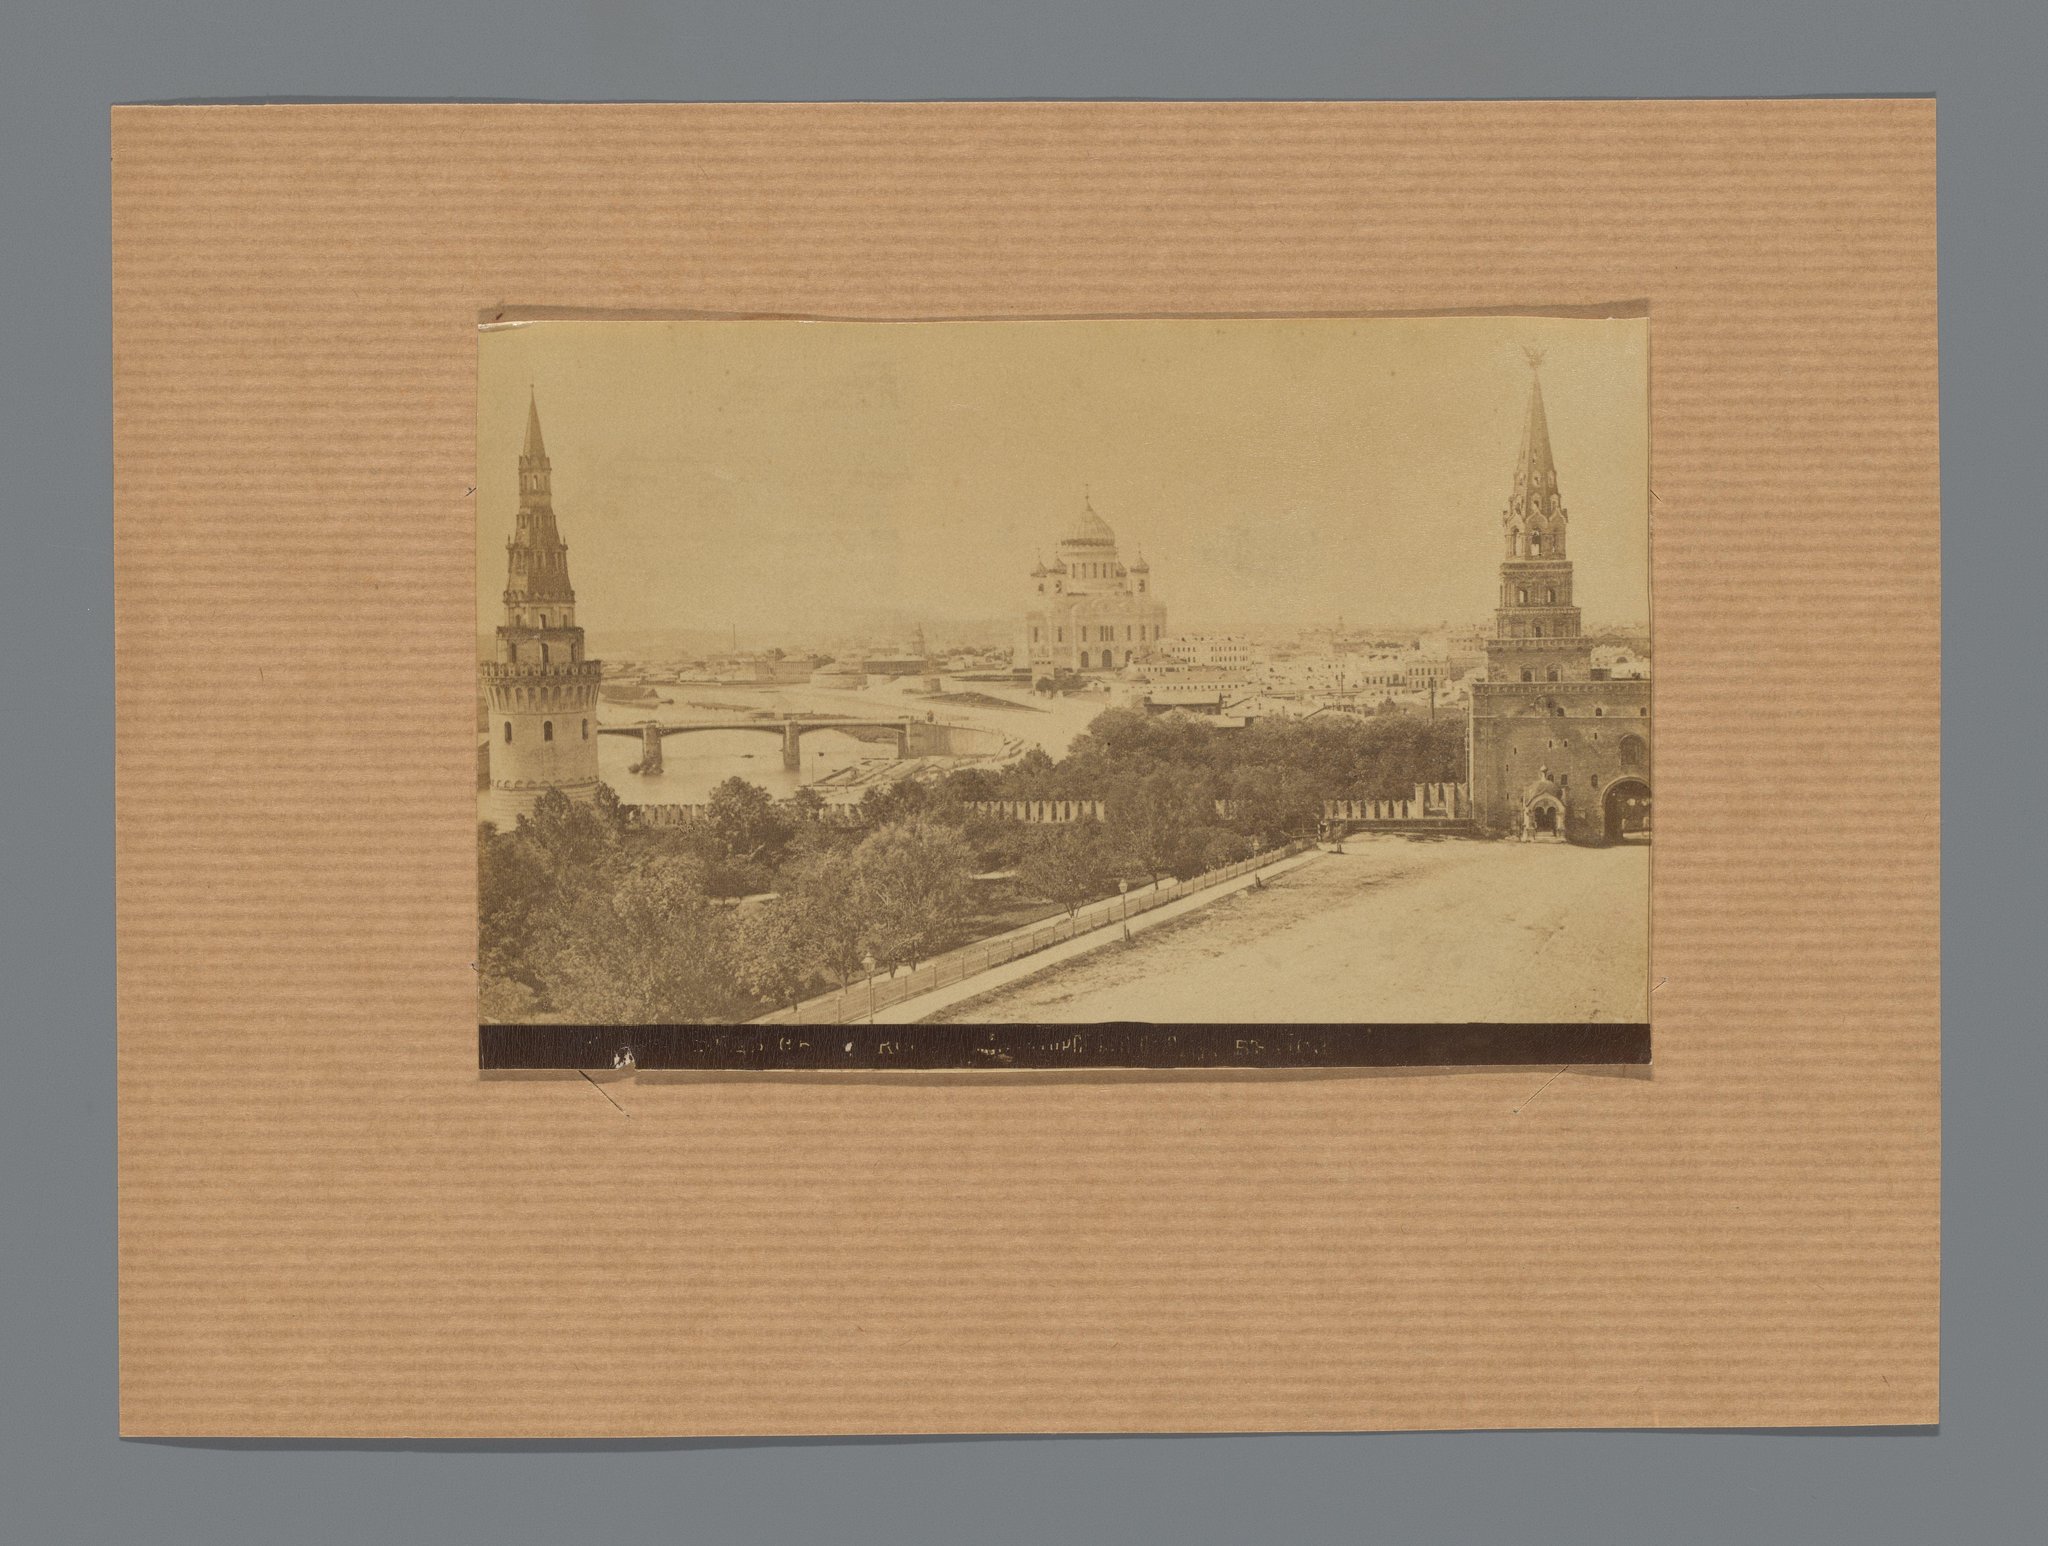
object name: photograph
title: Moskou. Algemeen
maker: Anonymous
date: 1850-1900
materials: photographic support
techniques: albumen print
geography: russia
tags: moskou